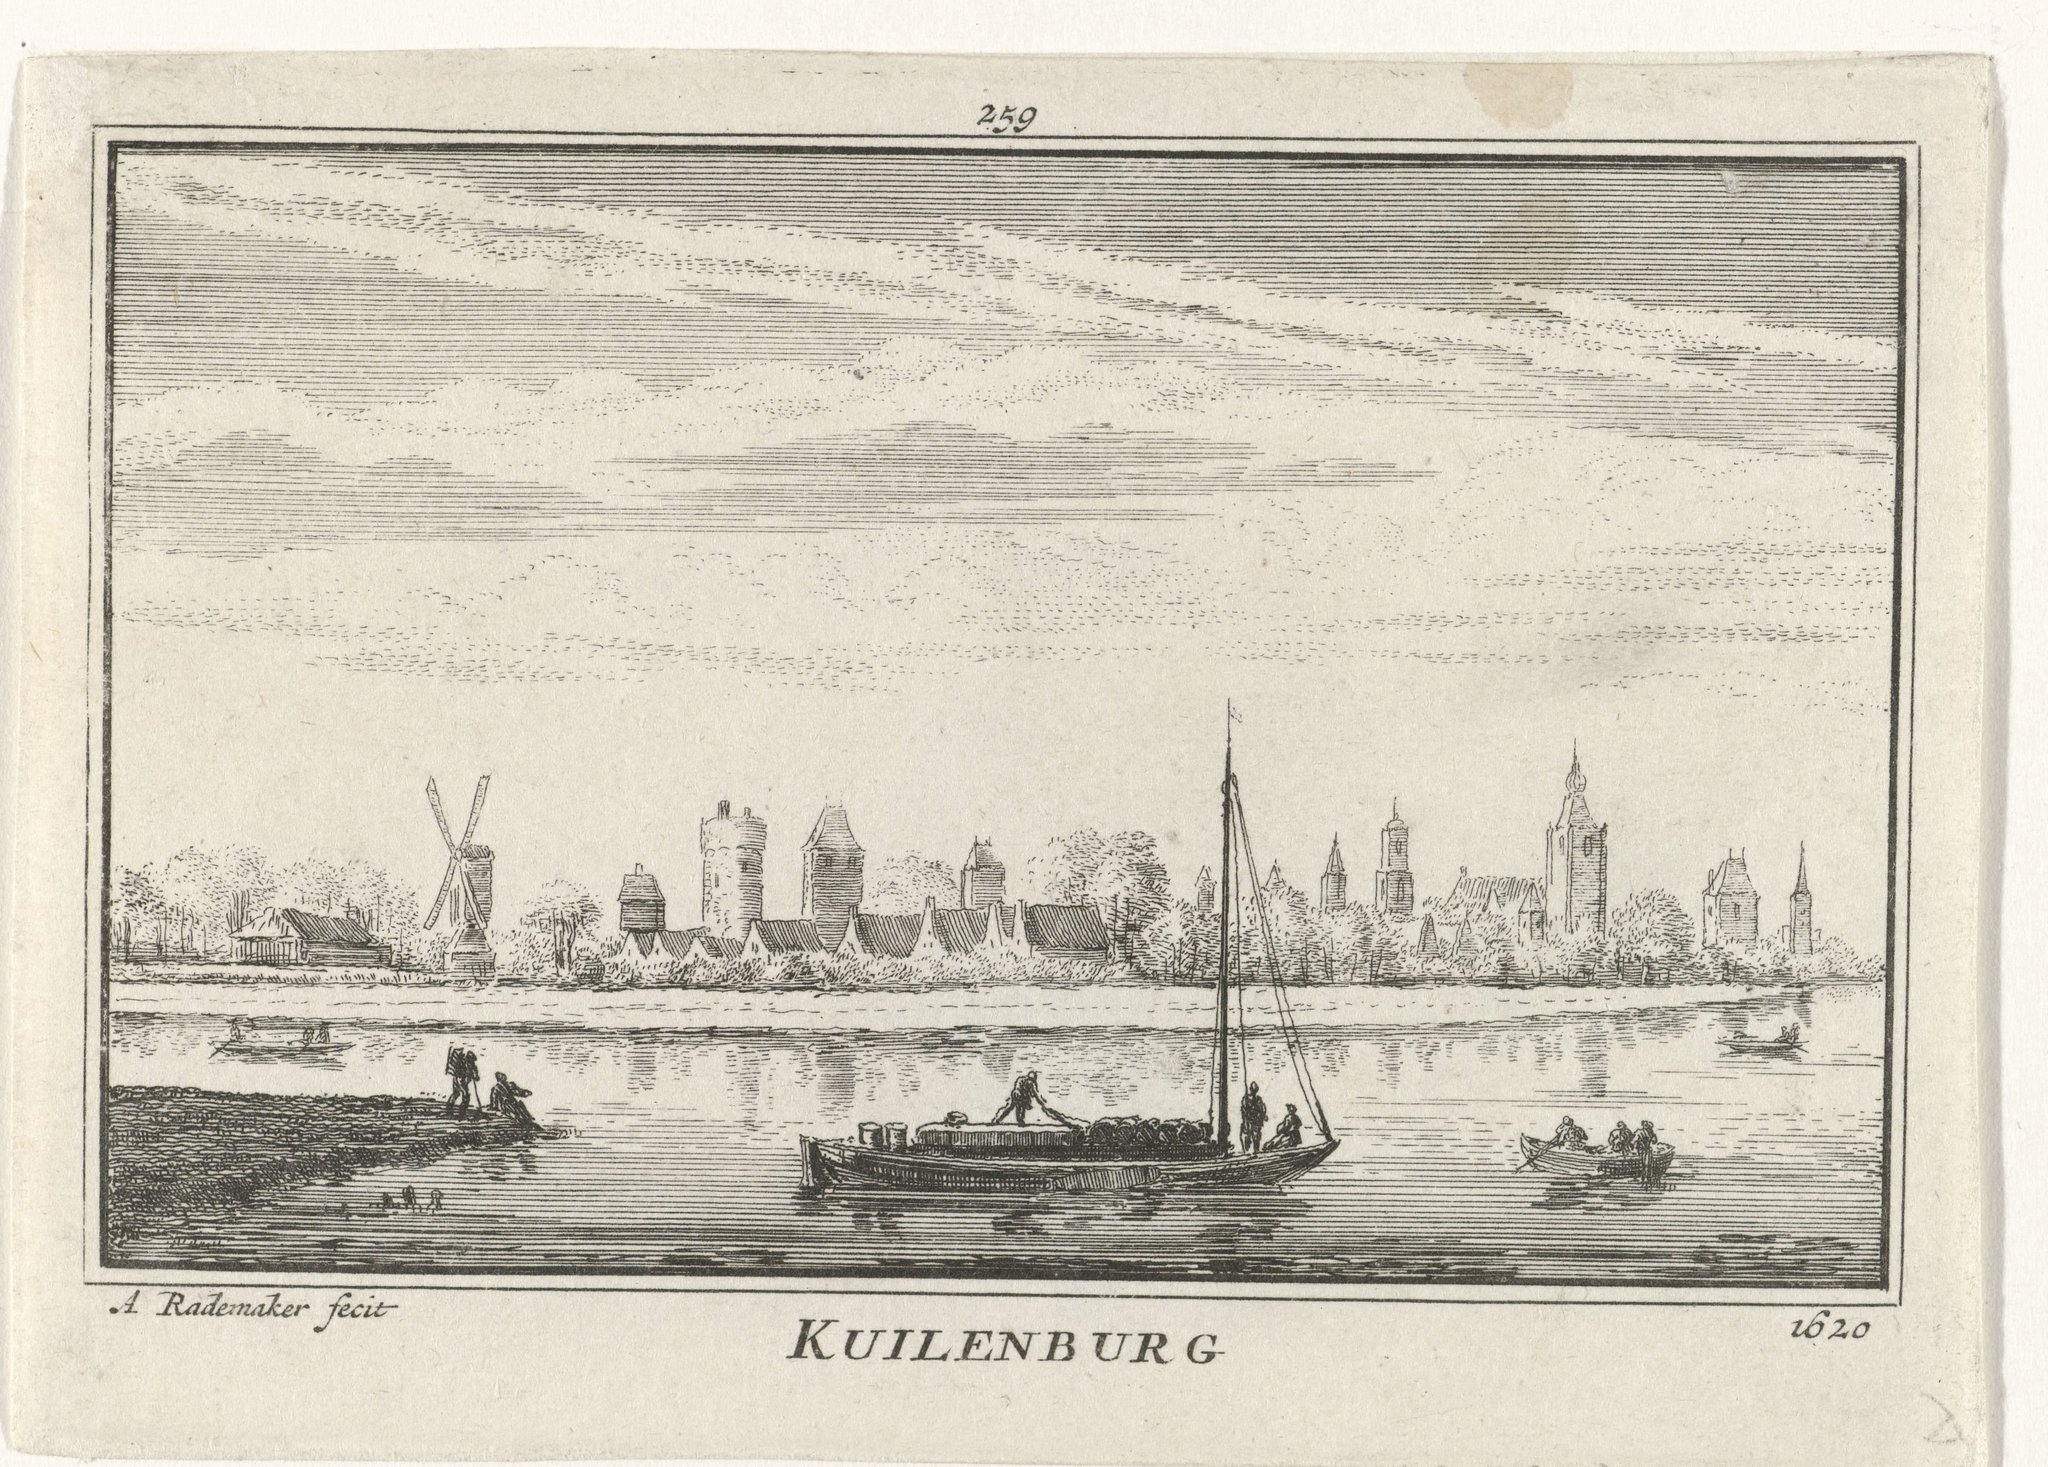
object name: print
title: Culemborg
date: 1727-1733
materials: paper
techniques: etching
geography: amsterdam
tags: church (exterior)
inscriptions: collector's mark: Lugt 2228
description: Illustratie uit: Abraham Rademaker, Matthaeus Brouërius van Niedek, Isaac Le Long, Kabinet van Nederlandsche en Kleefsche outheden en (...) voorname stads- en landgebouwen, Willem Barents en Antoni Schoonenburg: Amsterdam, 1727-1733, ill. nr. 259.